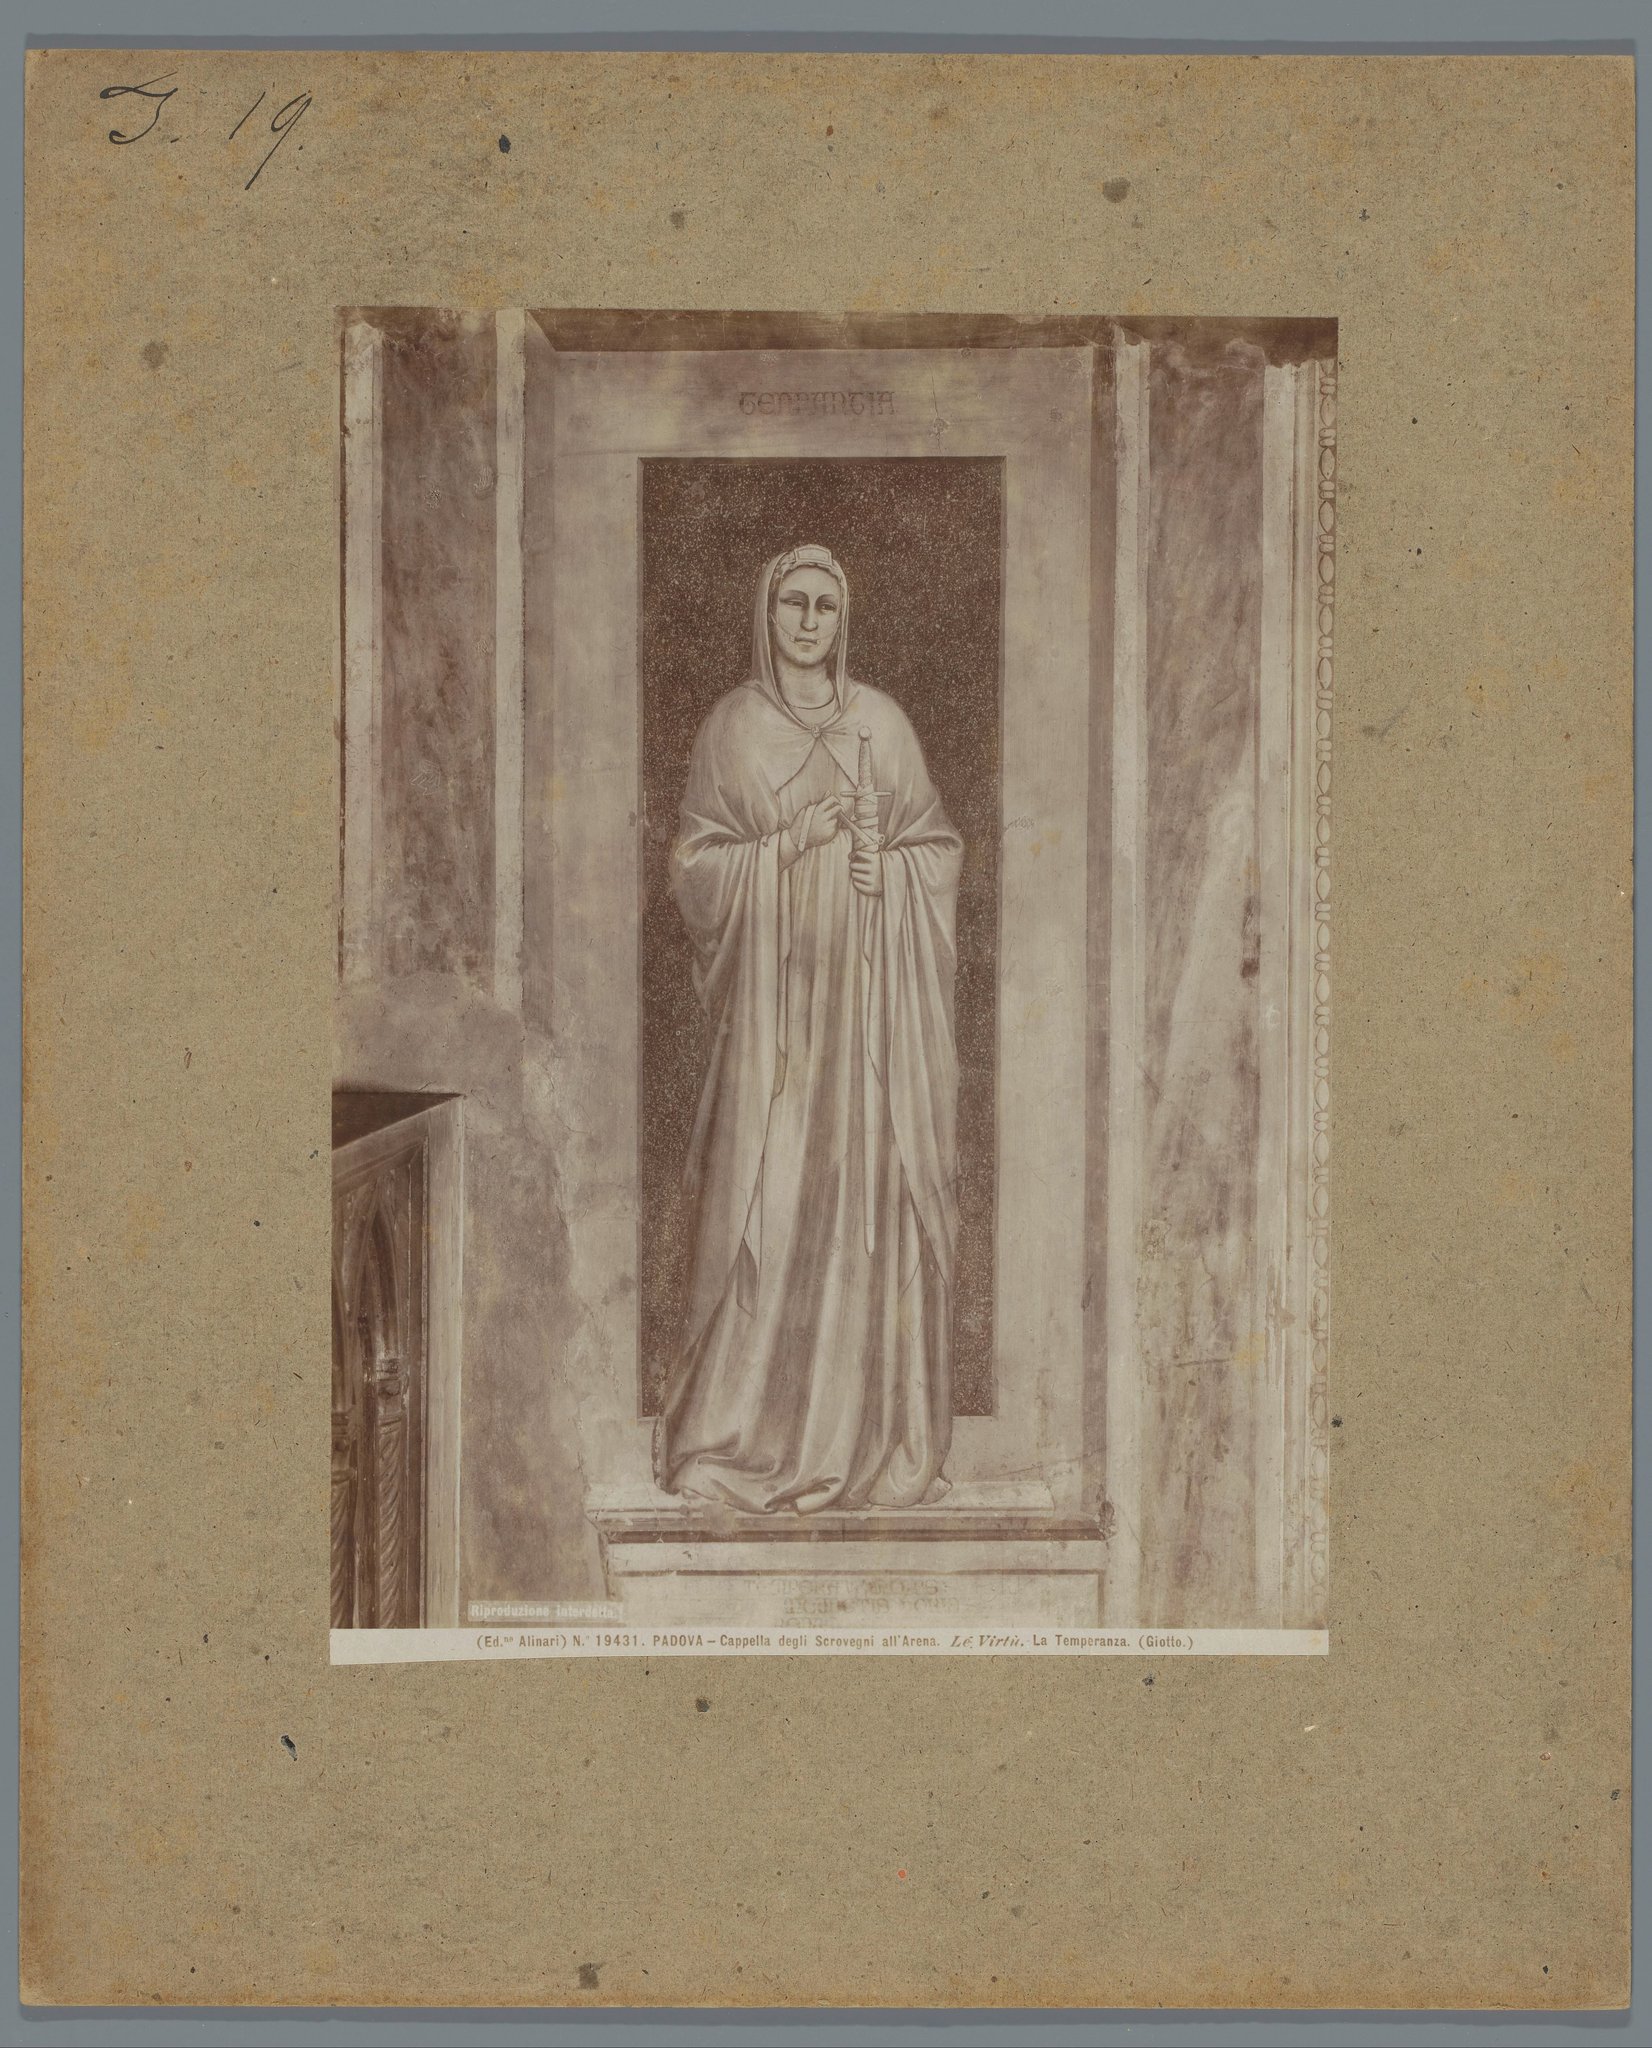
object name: reproduction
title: PADOVA - Cappella degli Scrovegni all'Arena. Le Virtù. La Temperanza.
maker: giotto de bondone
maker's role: painter, sculptor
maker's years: 1266-1337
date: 1875-1900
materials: cardboard, photographic support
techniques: albumen print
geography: scrovegnikapel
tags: temperance, 'temperantia'; 'temperanza' (ripa) ~ one of the four cardinal virtues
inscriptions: collector's mark: Lugt 3937, number: ‘No. 19431.’